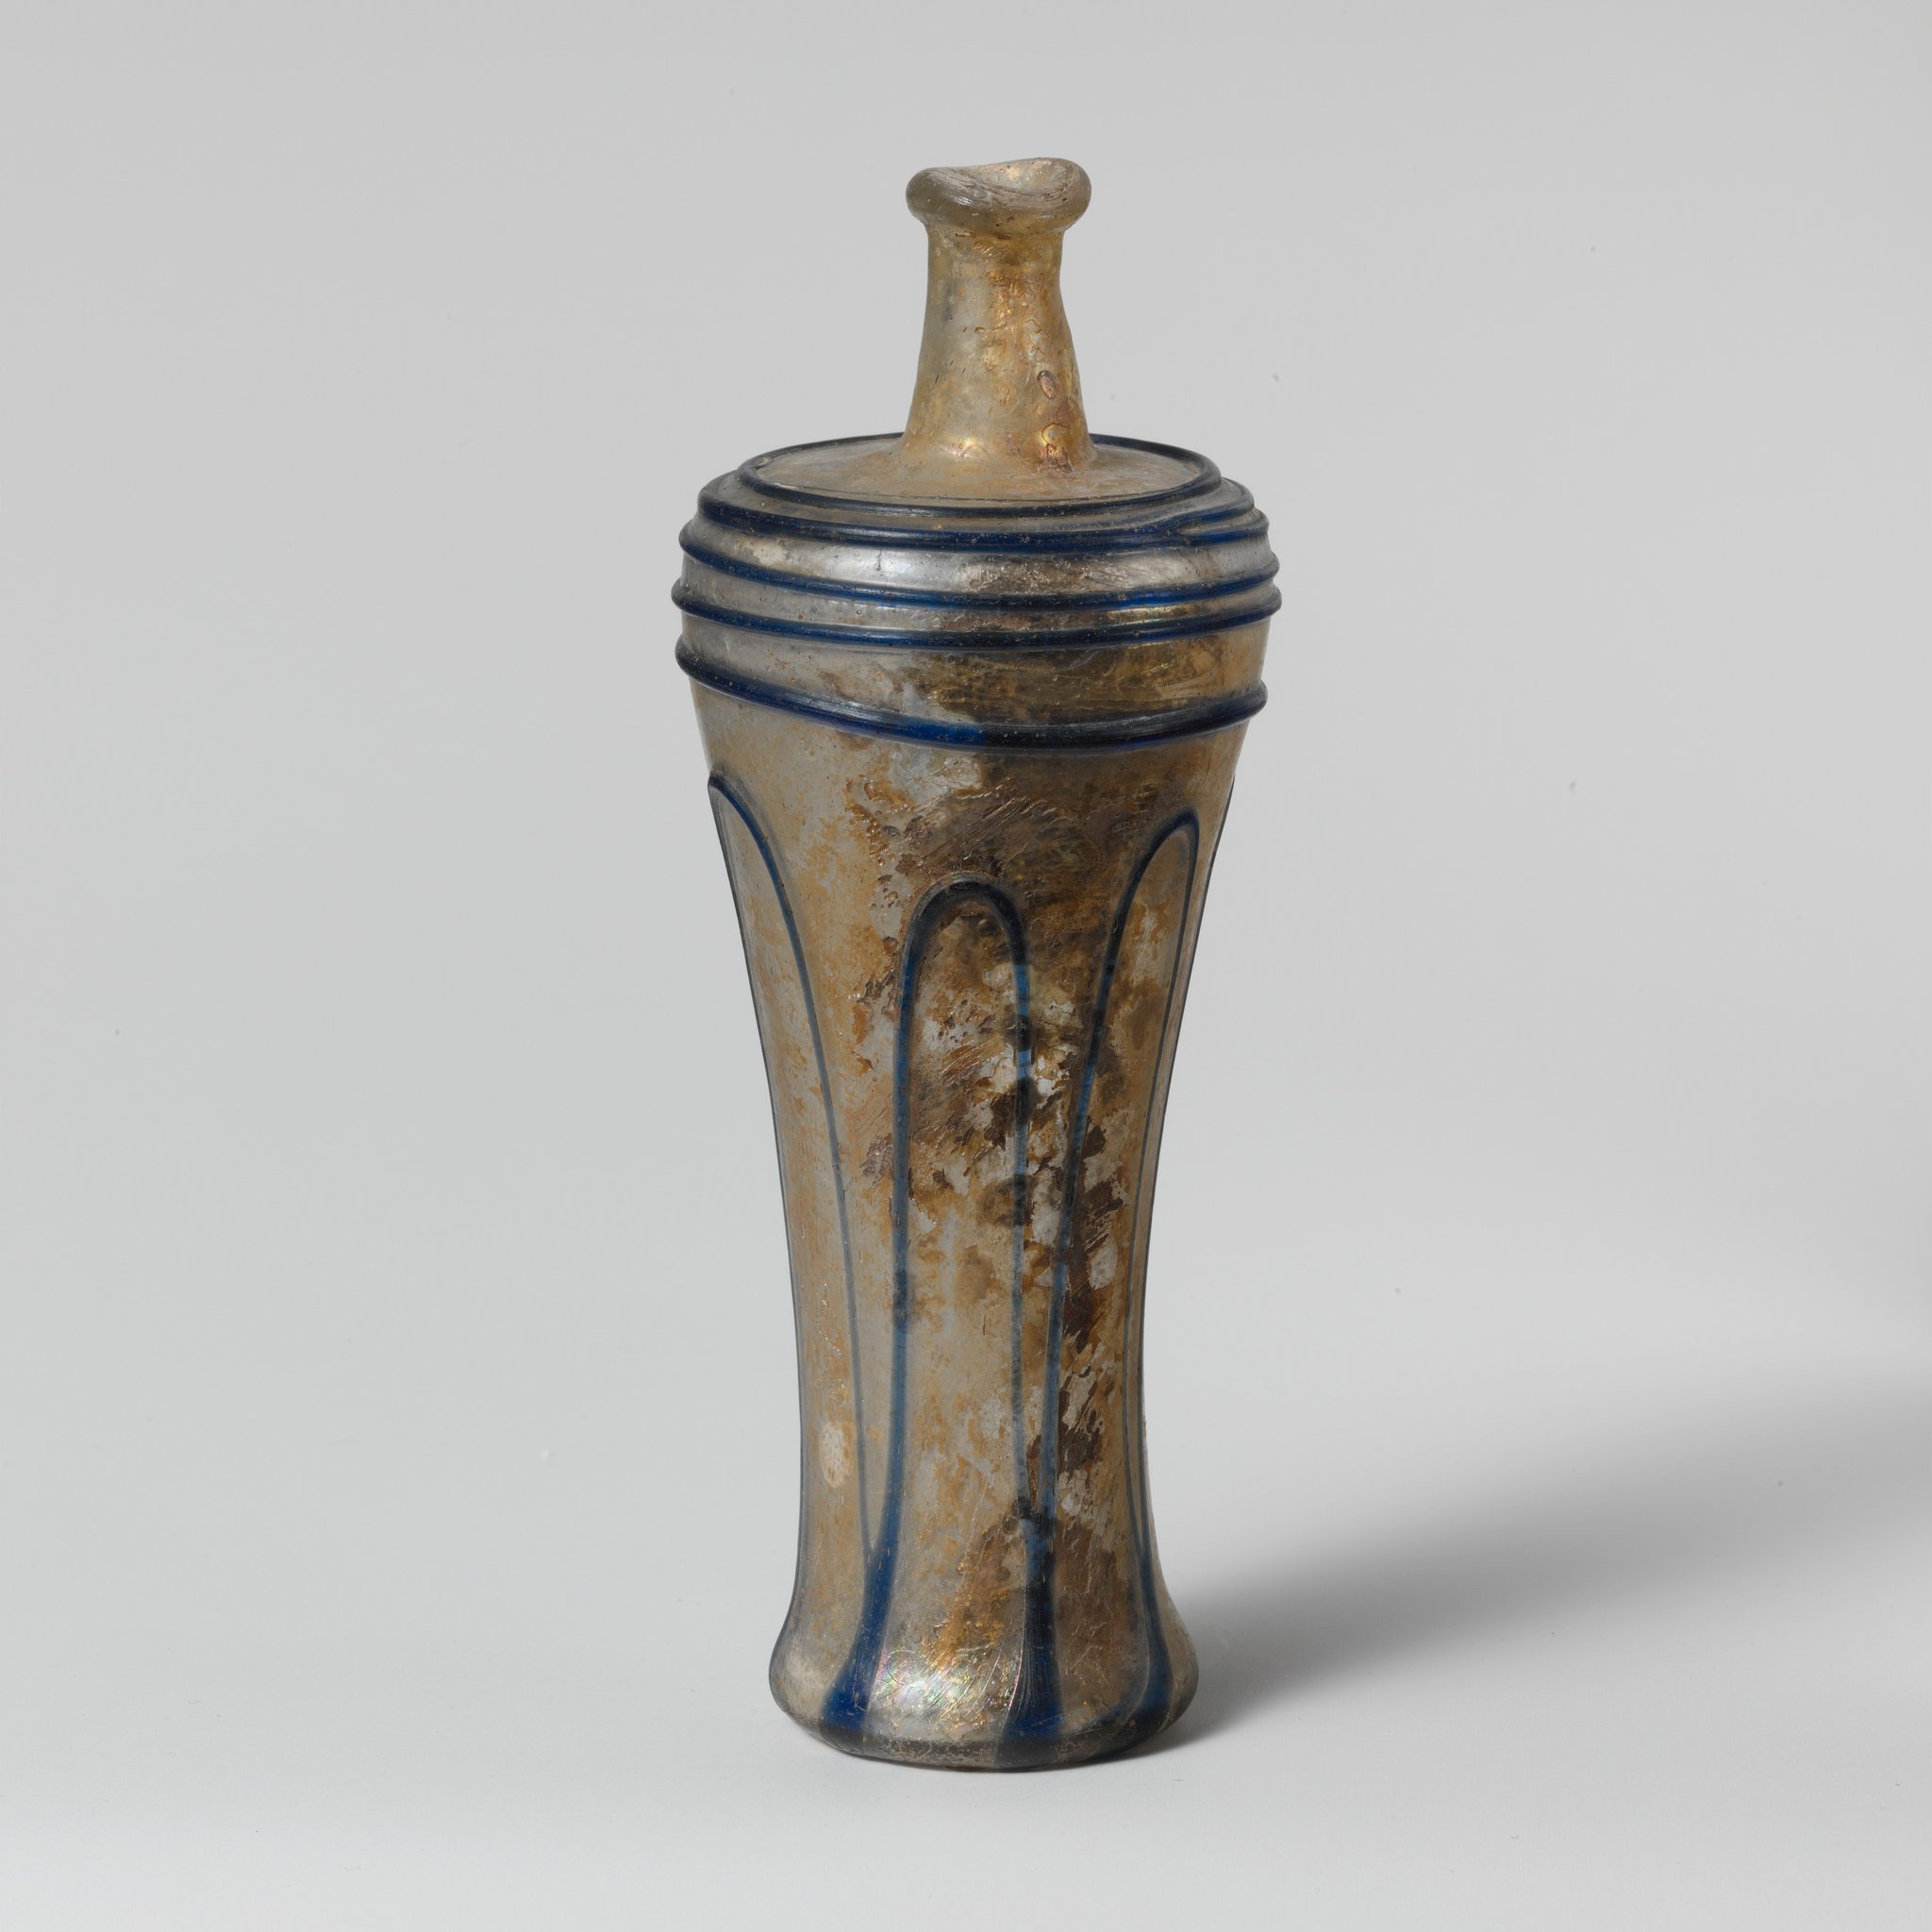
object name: bottle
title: Glass bottle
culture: roman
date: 201-300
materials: glass